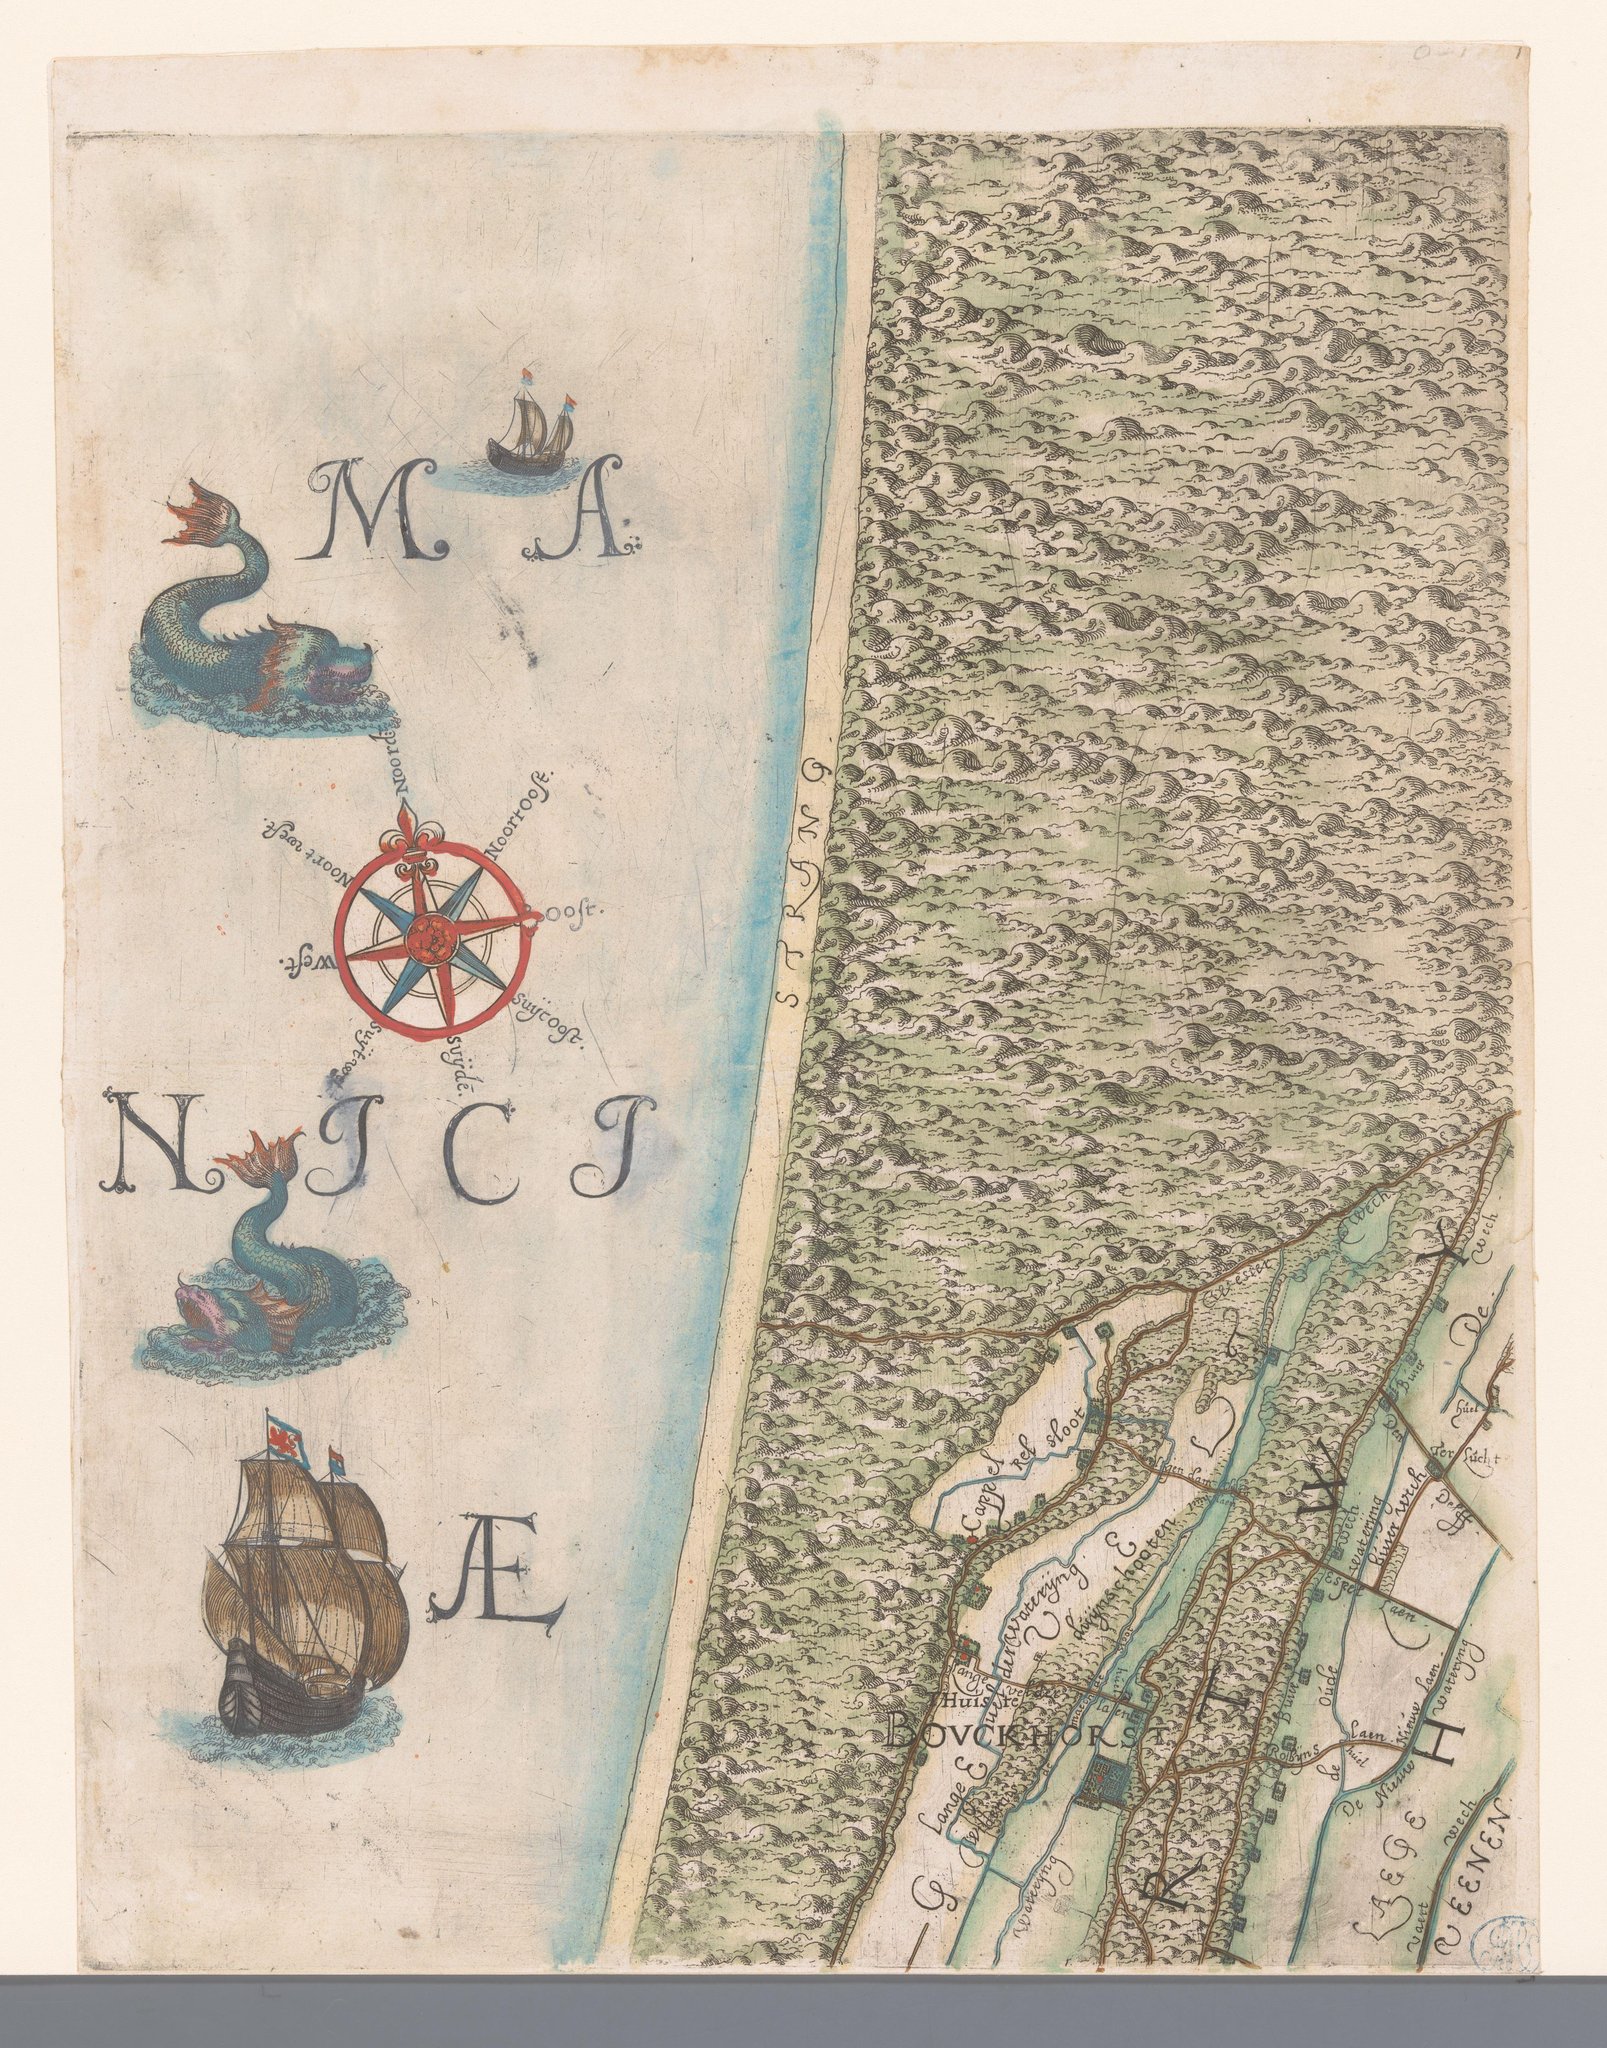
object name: print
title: Deel van een kaart van het Hoogheemraadschap van Rijnland, met Huis te Boekhorst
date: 1615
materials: paper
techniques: engraving, etching, hand coloring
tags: maps of separate countries or regions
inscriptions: collector's mark: Lugt 195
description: Deel van een kaart van Rijnland, bestaande uit 27 delen.